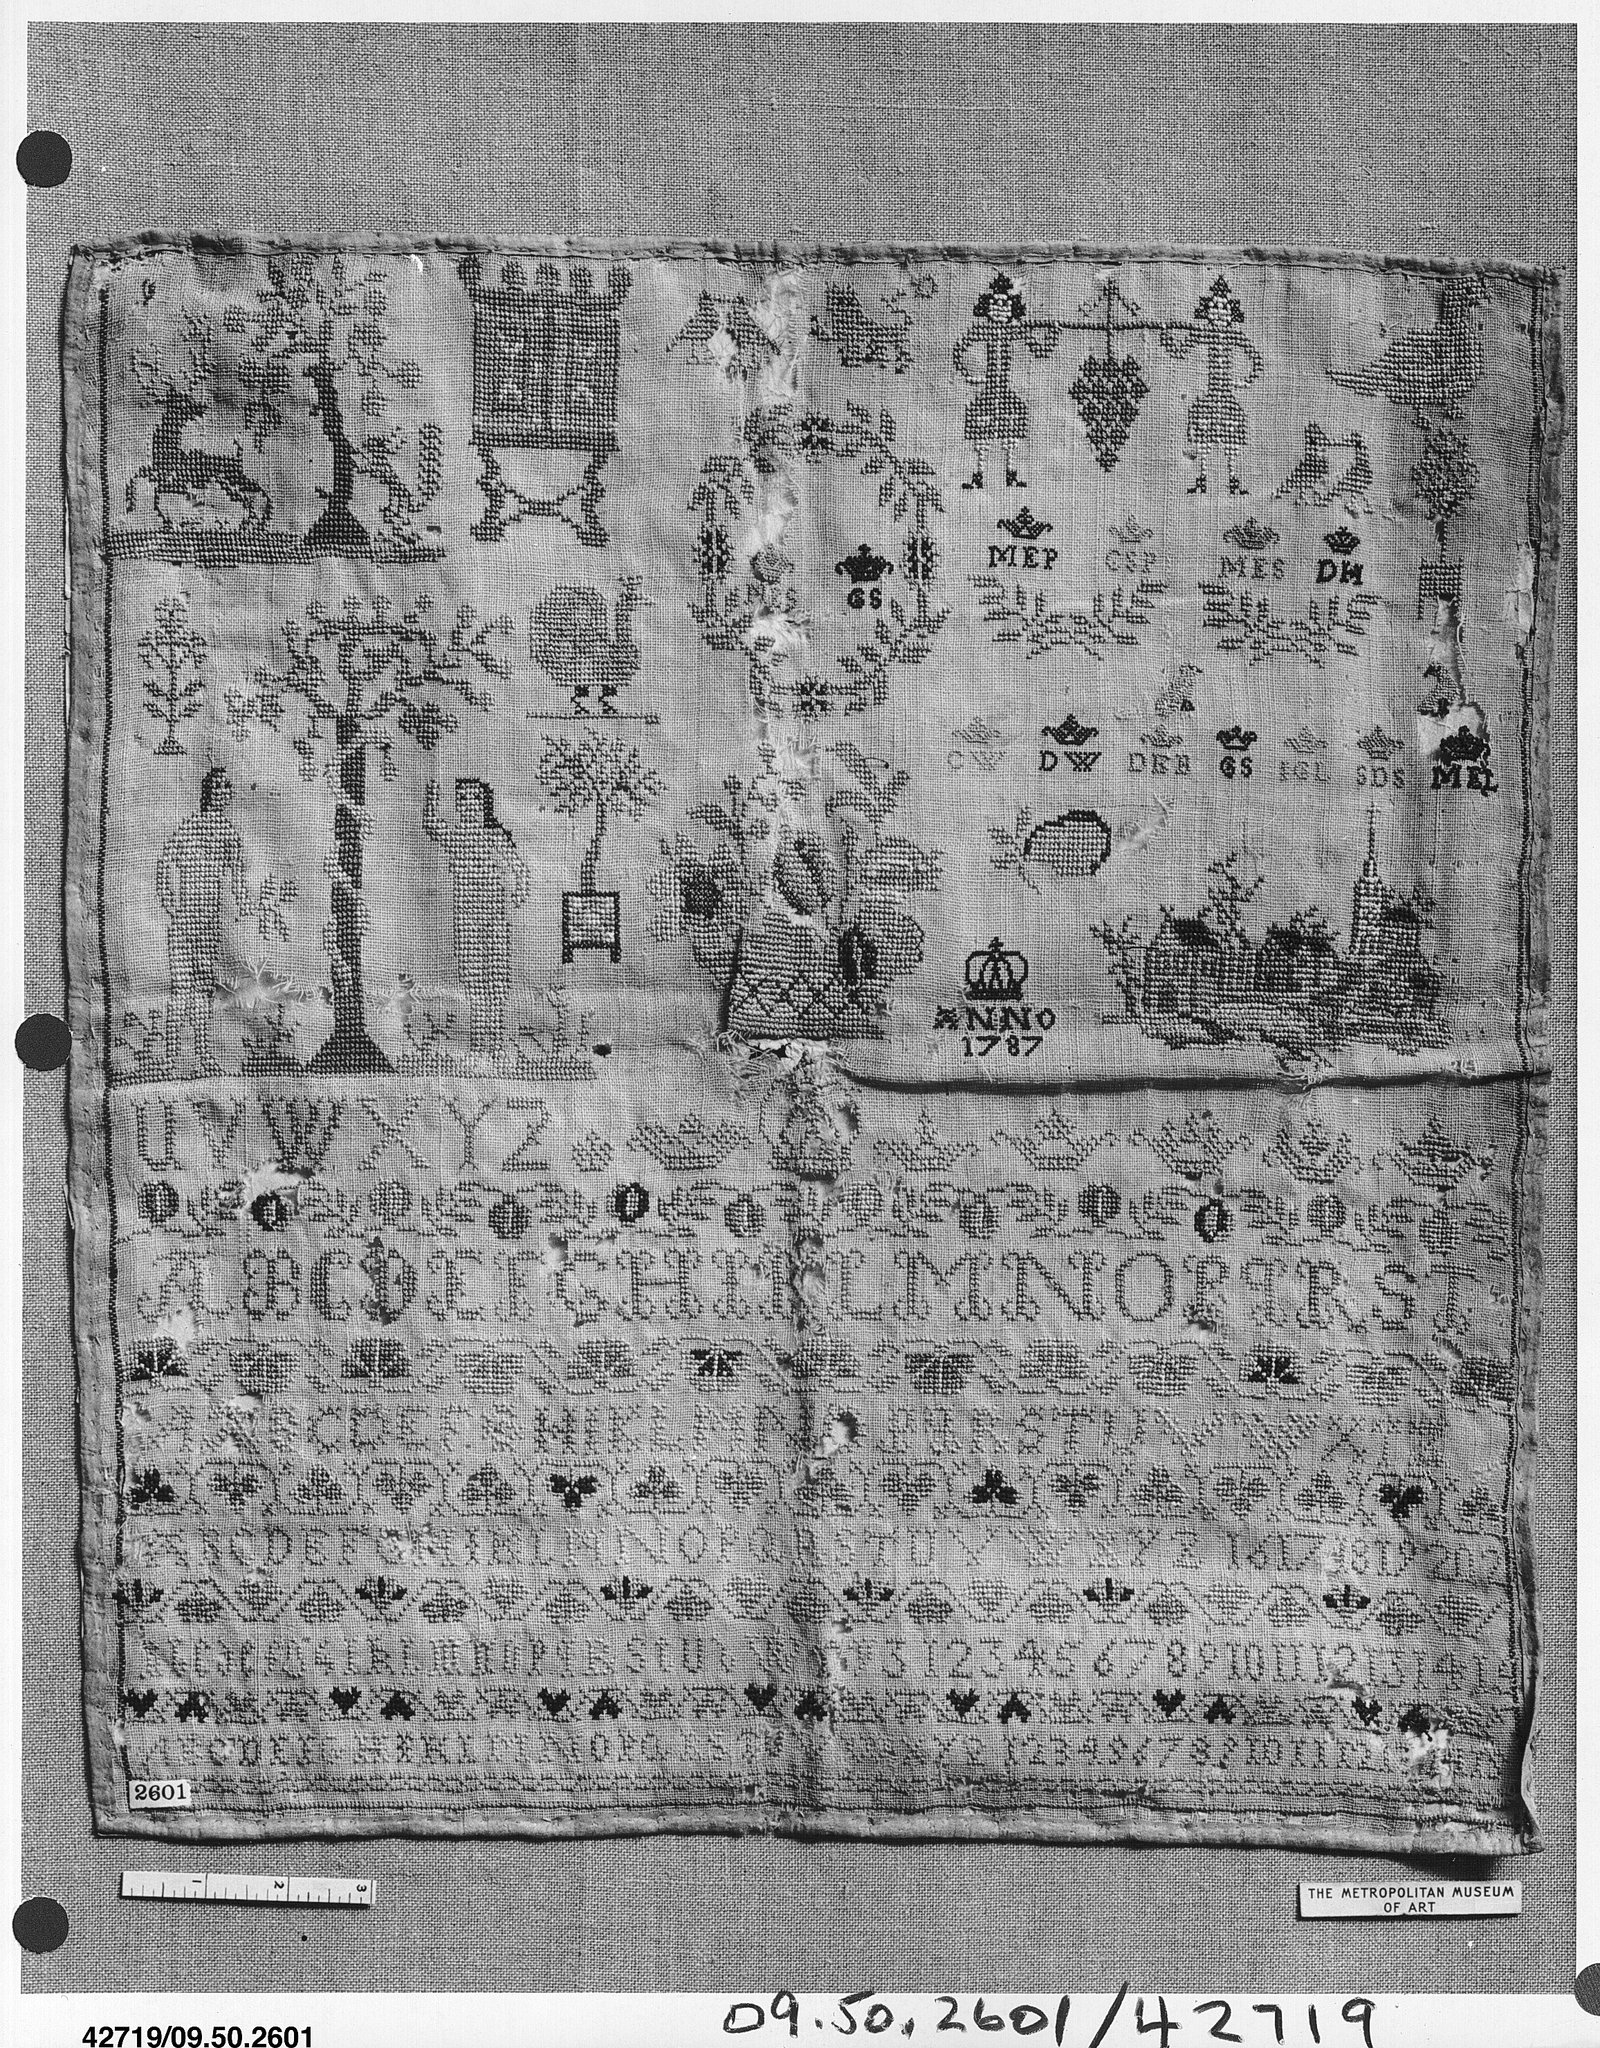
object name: sampler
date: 1787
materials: canvas, silk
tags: animals,adam,eve